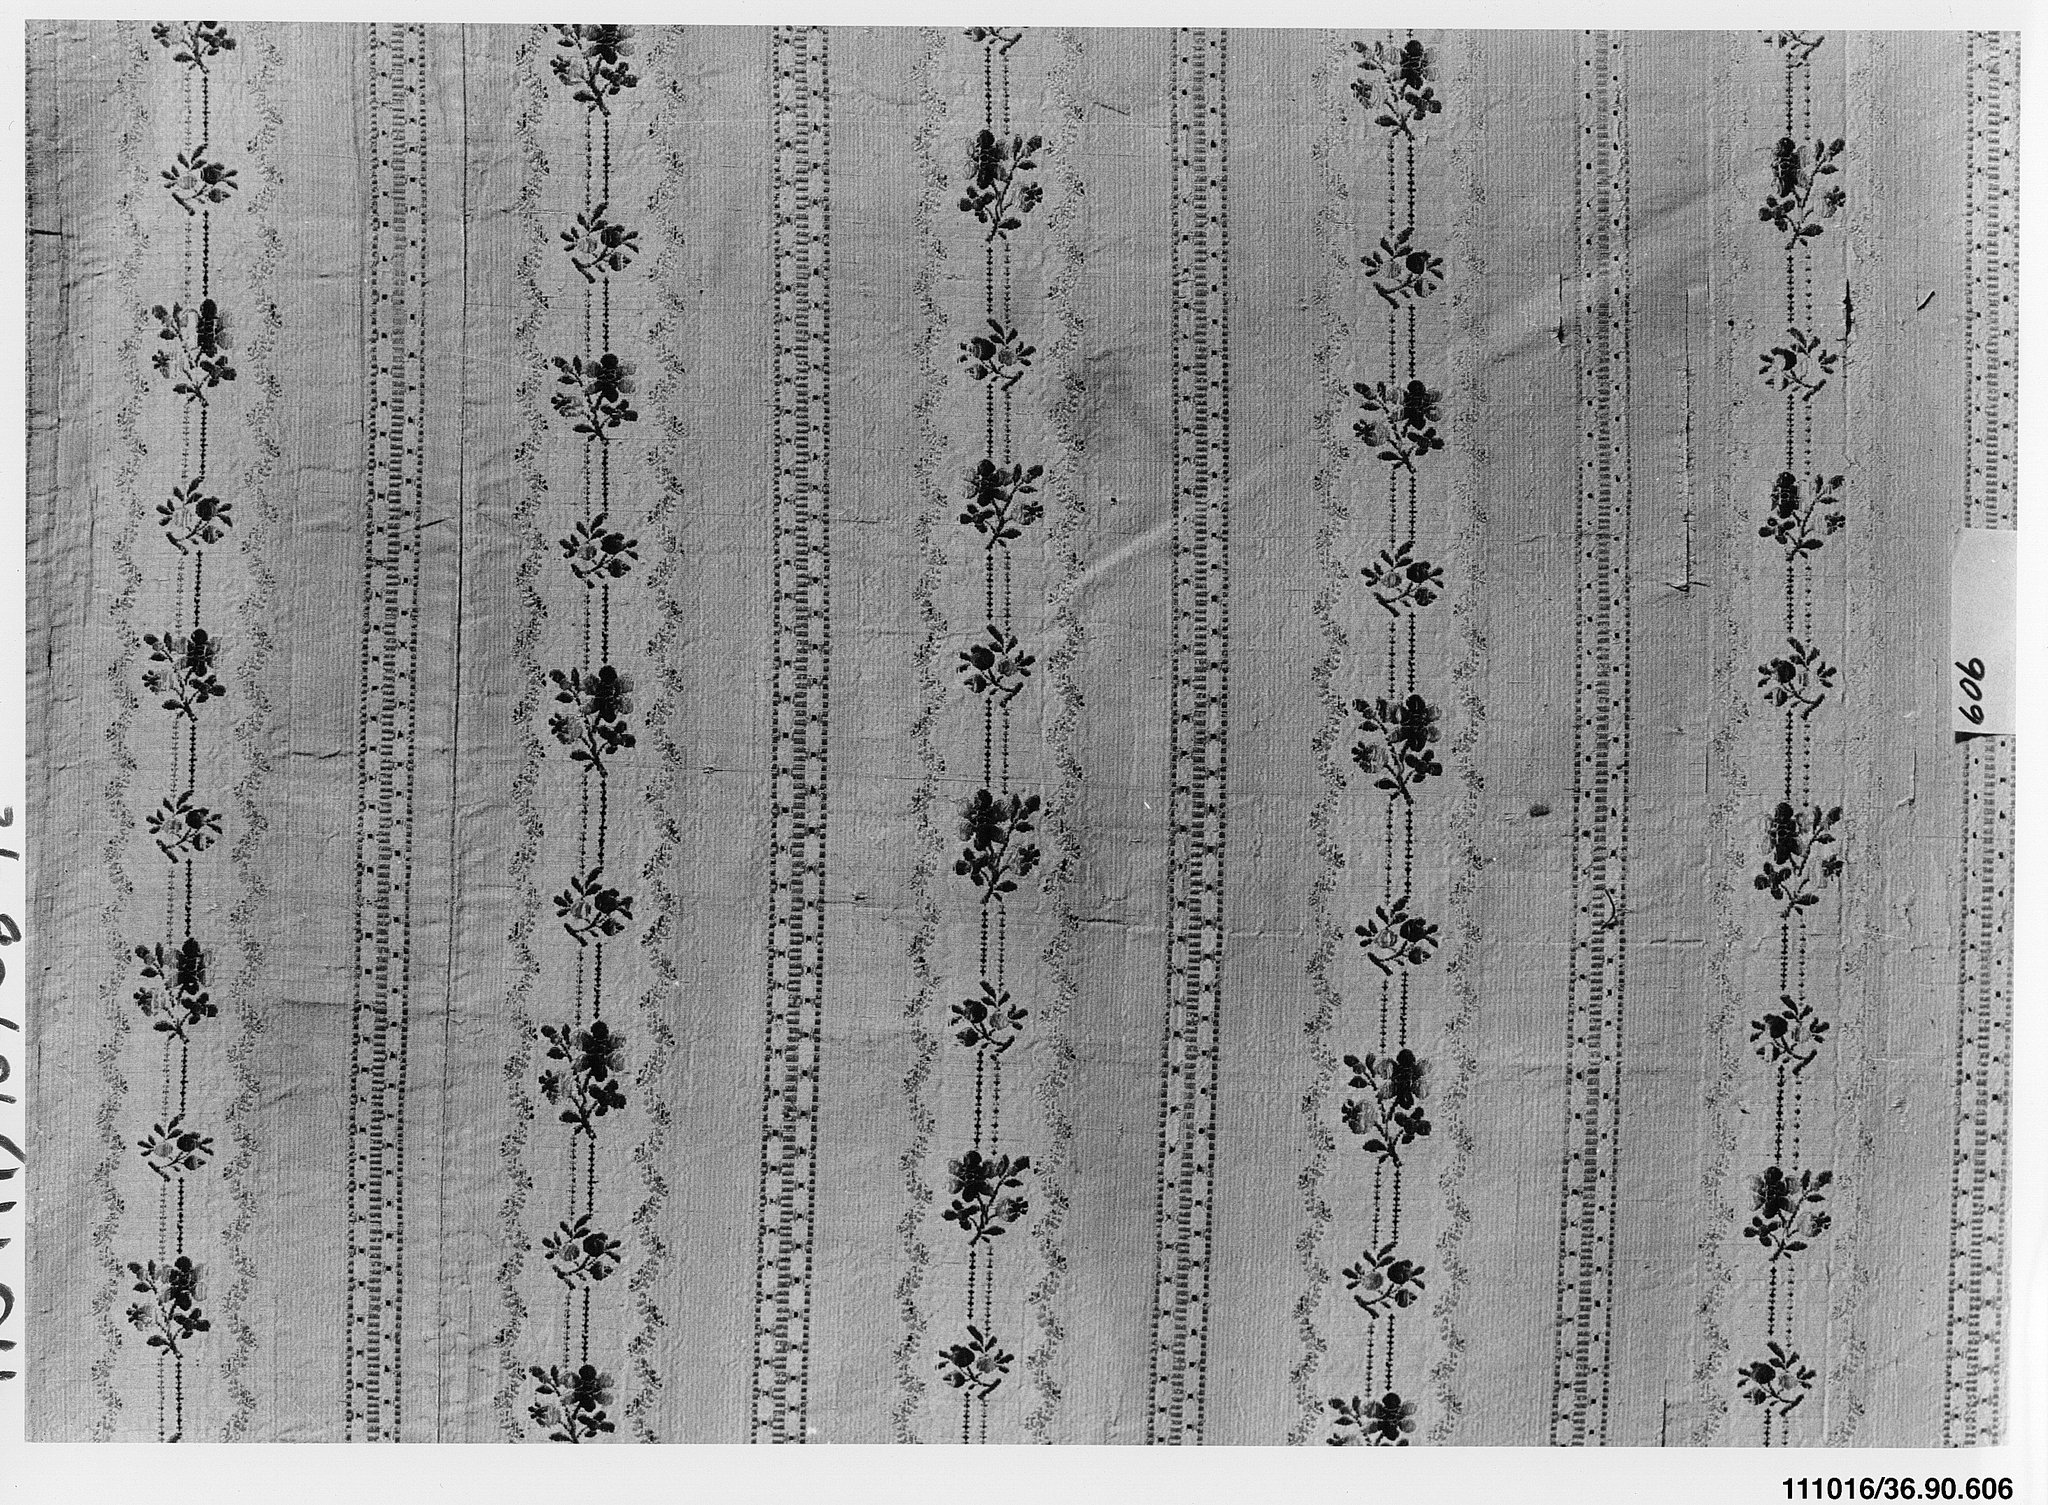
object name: piece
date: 1701-1800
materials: silk